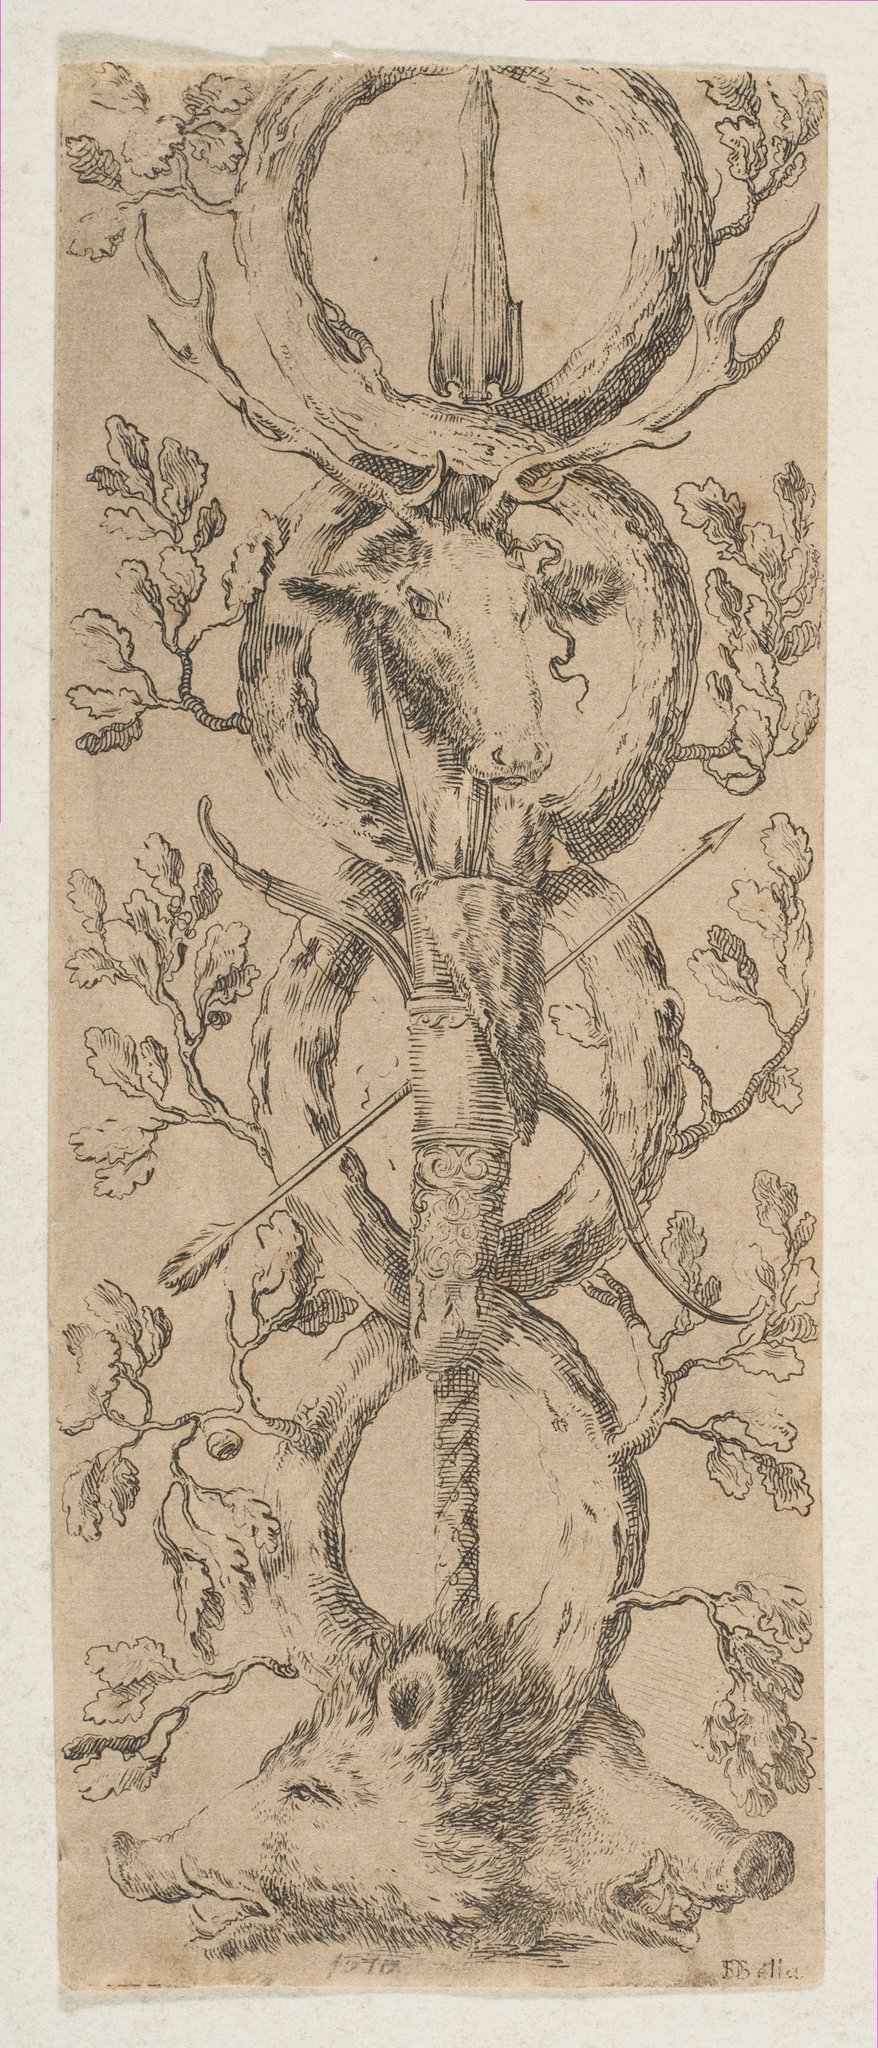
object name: print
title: Heads of a Stag and Two Boars in Rinceaux of Oak Branches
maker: stefano della bella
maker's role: artist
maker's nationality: italian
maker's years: 1610-1664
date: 1653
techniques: etching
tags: bow and arrow,boars,deer,oaks